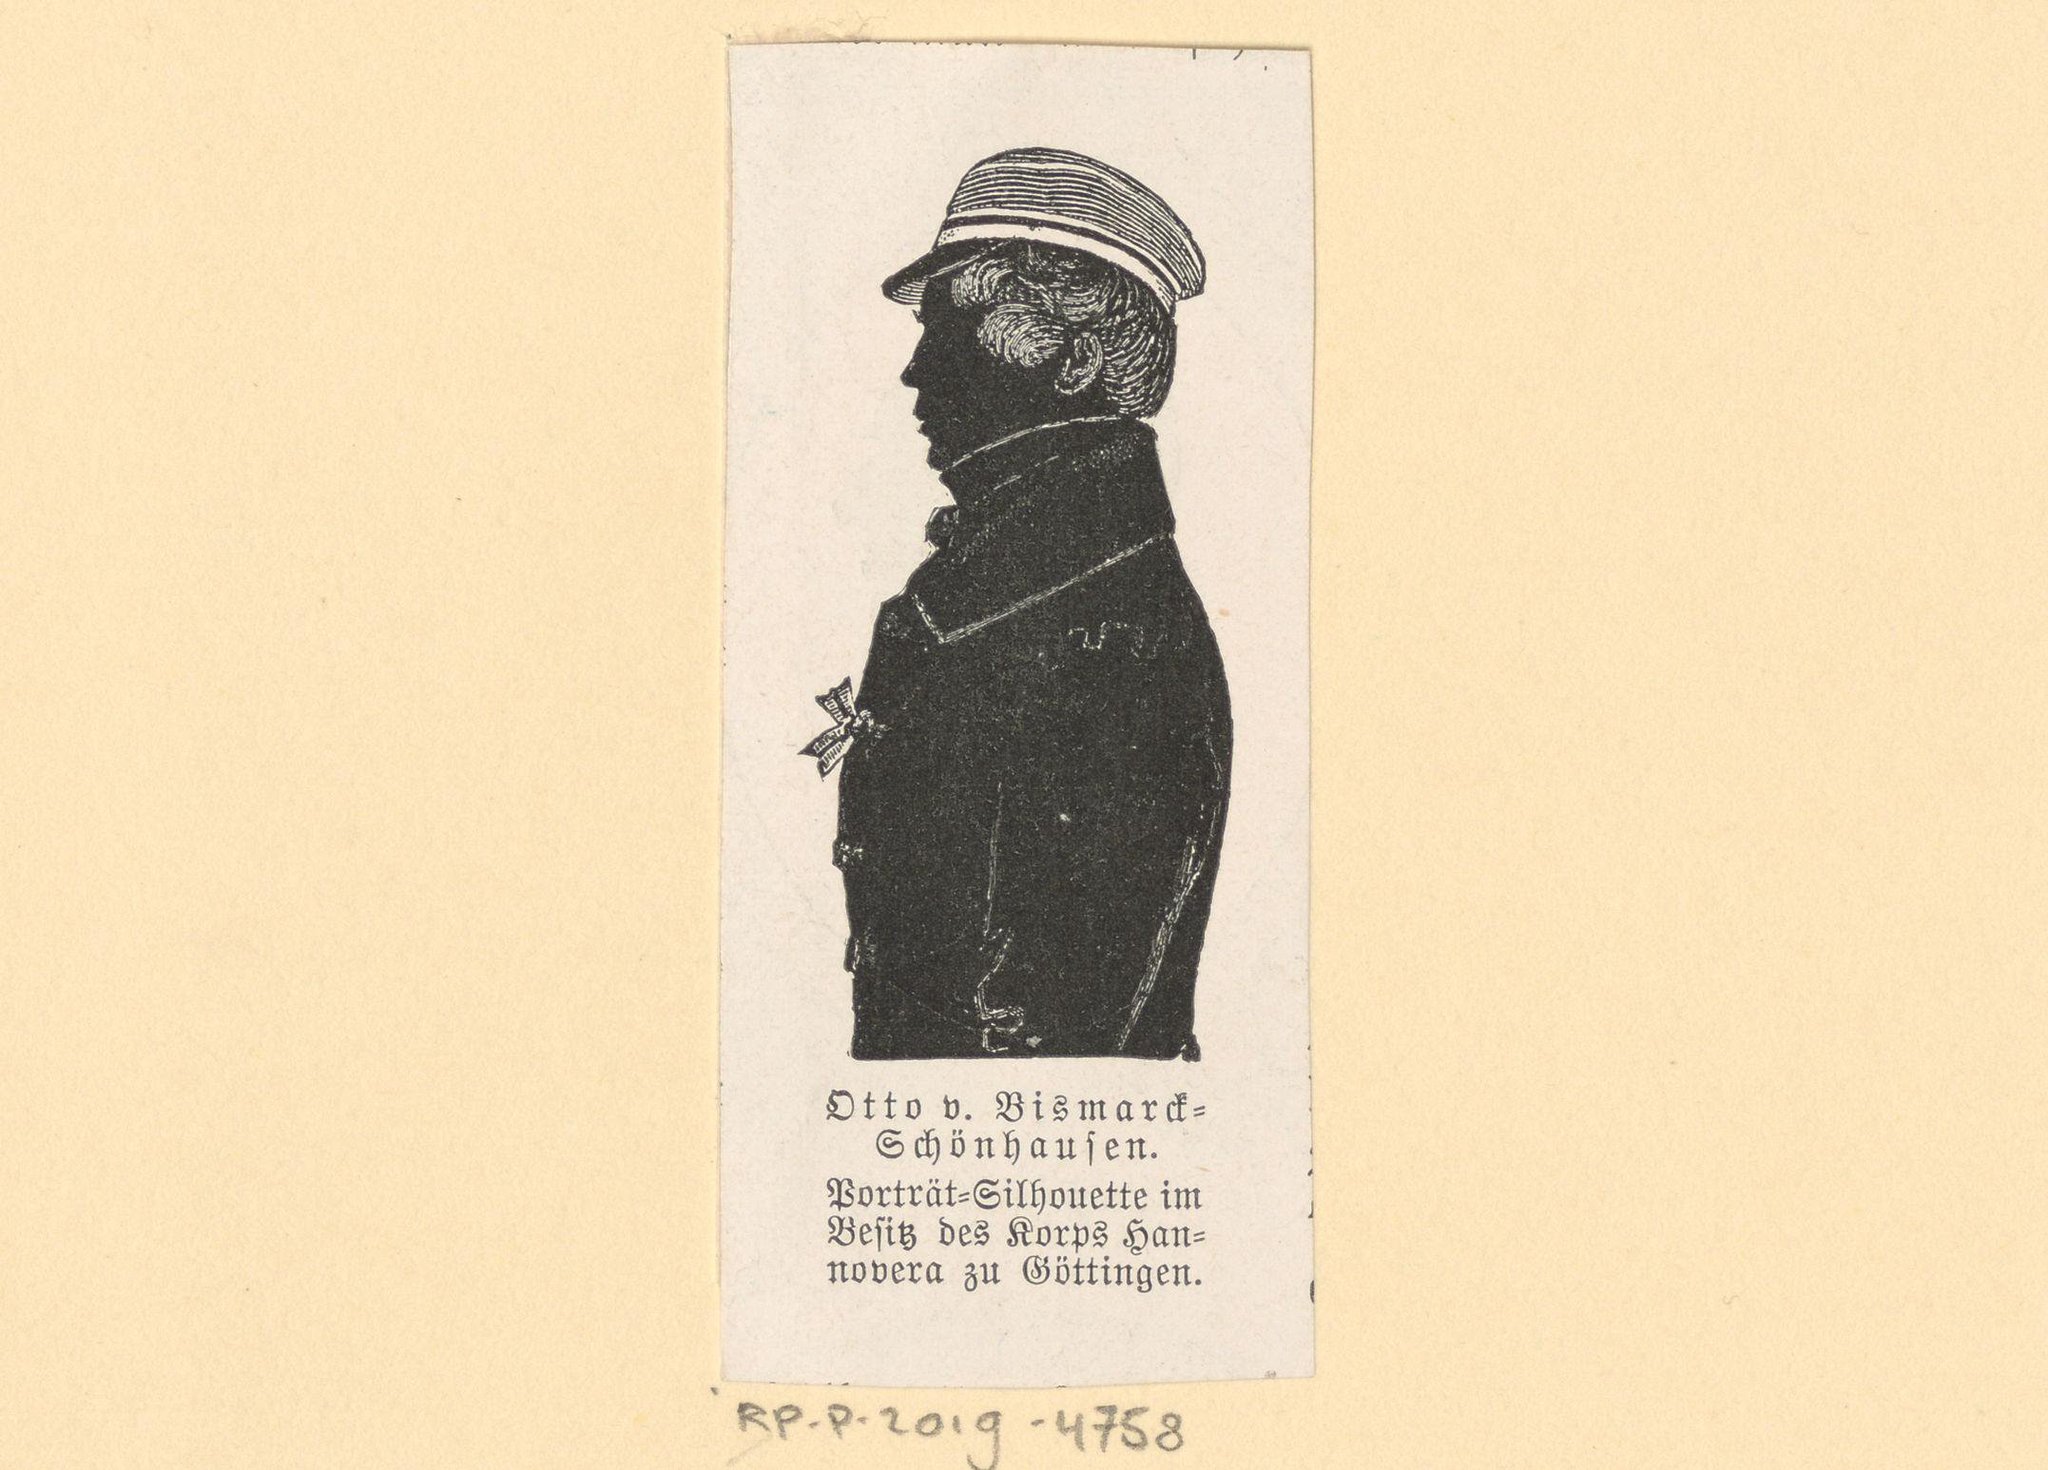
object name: book illustration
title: Silhouetportret van Otto von Bismarck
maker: Anonymous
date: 1875-1925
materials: paper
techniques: letterpress printing, printing block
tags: historical persons